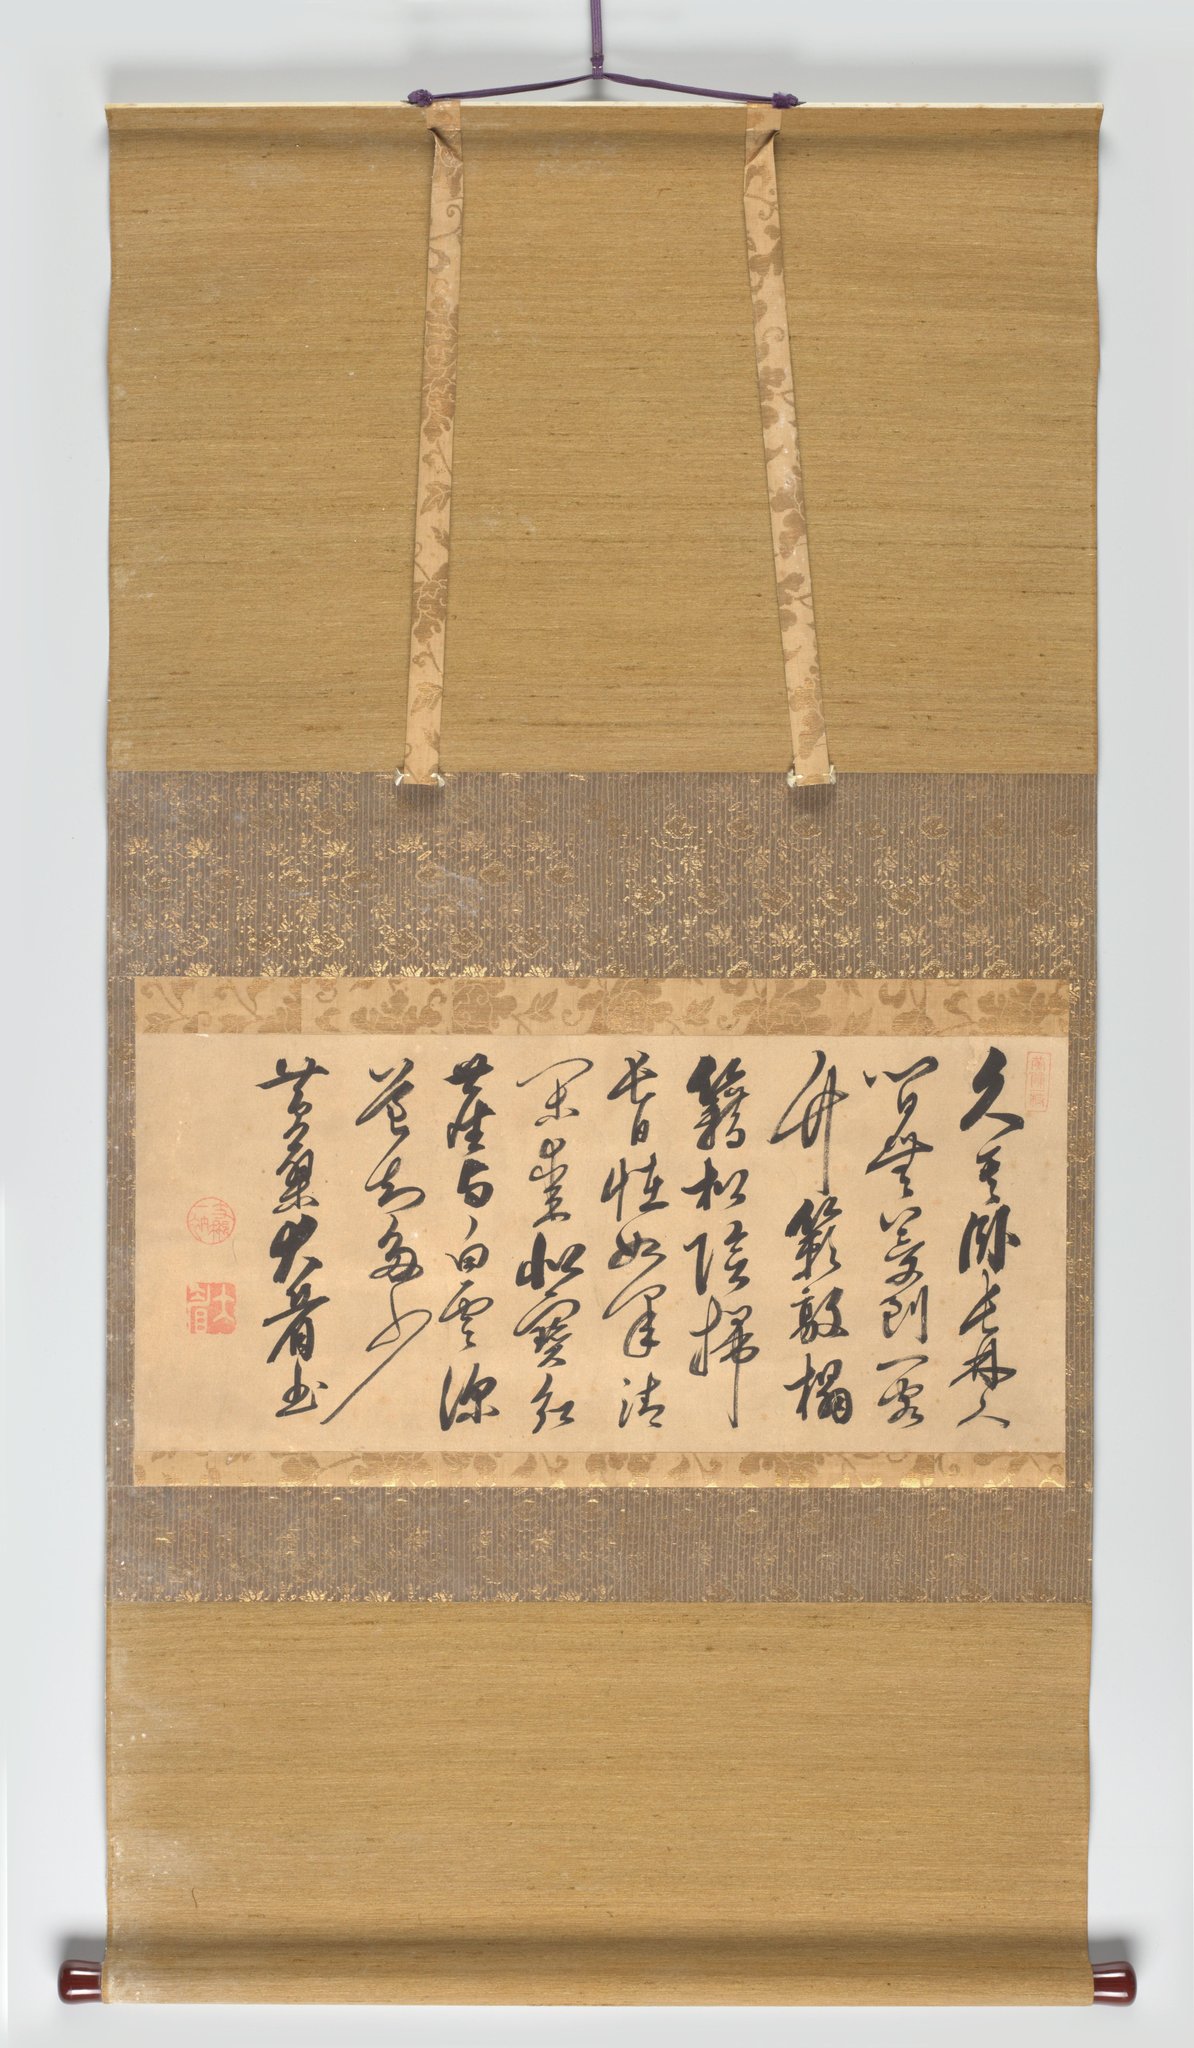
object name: hanging scroll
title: Zen-kalligrafie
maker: daibi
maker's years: 1616-1673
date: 1616-1673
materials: ink, paper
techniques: calligraphy